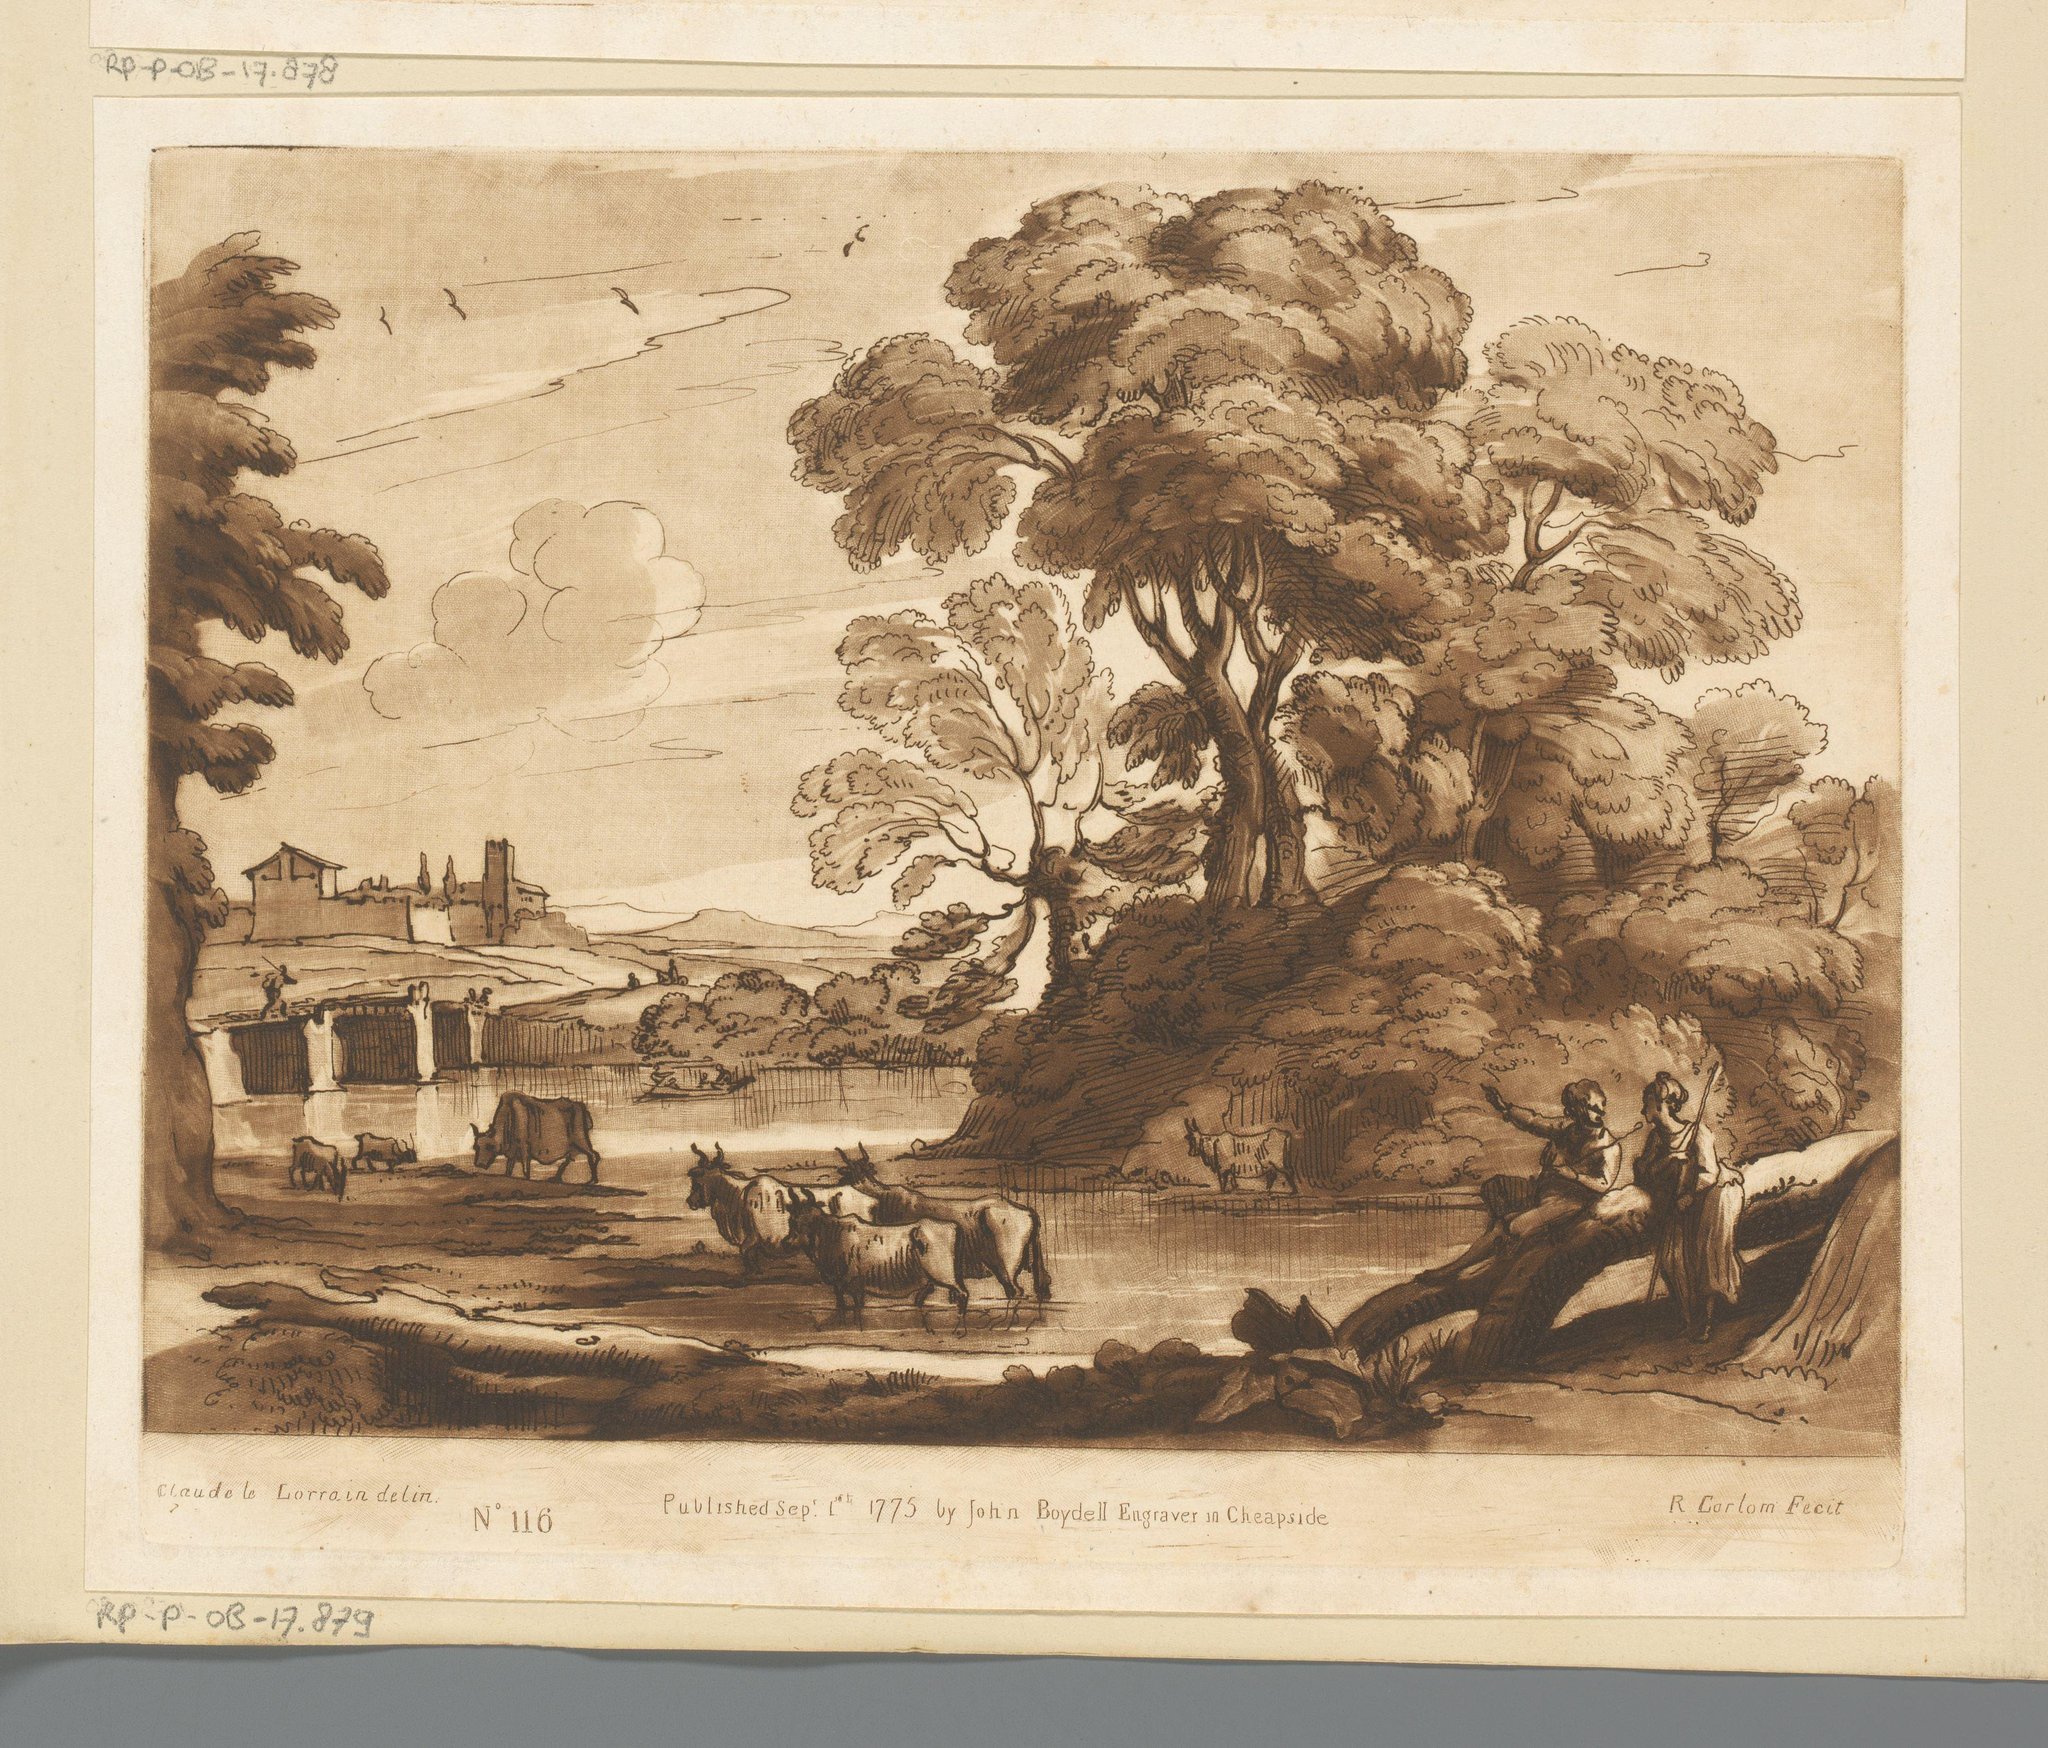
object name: print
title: Landschap met vee, herderin en herder die wijst naar een dorp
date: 1775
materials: paper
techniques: etching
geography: london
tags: river - hh - ideal landscapes, city-view, and landscape with man-made constructions - ii - ideal landscapes, herding, herdsman, herdswoman, shepherd, shepherdess, cowherd, etc., cattle, pastorals, arcadian scenes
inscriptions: date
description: Vanaf 1774 publiceerde John Boydell tweehonderd prenten naar het tekeningenboek Liber Veritatis van Claude Lorrain, in het bezit van de hertogen van Cavendish. Deze prenten werden vanaf 1777 in twee volumes gebundeld uitgegeven.